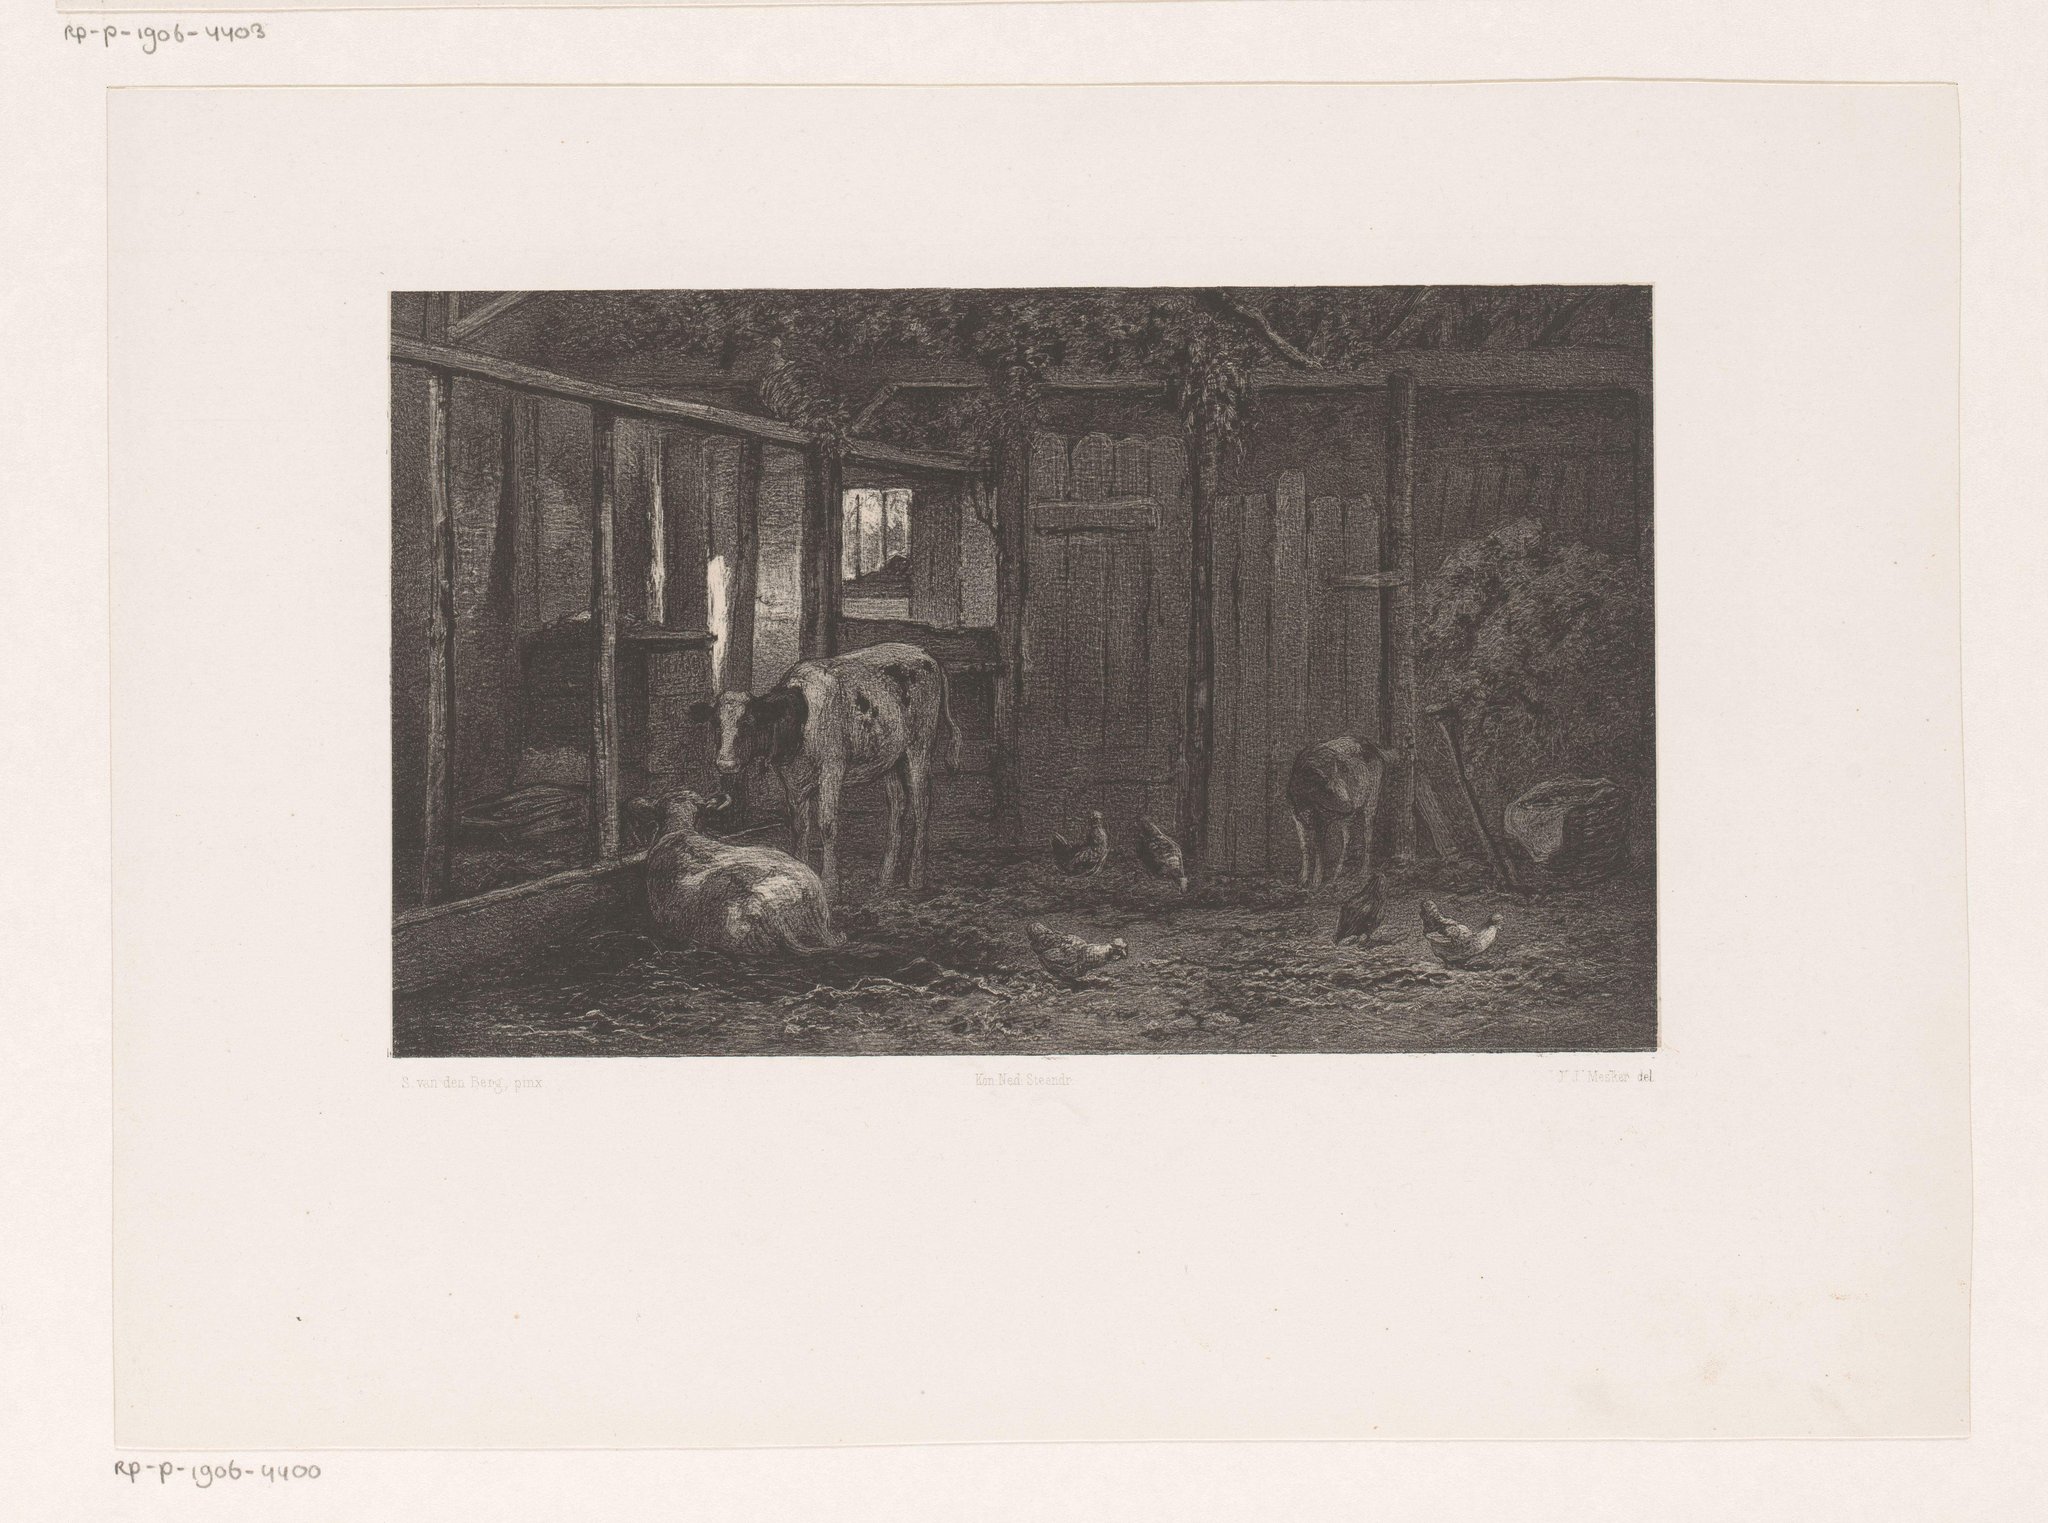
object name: print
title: Stal met koeien, kippen en een varken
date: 1867-1874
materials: paper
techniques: lithograph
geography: the hague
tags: pig, cow, fowl (cock, hen, chicken, etc.), stall, stable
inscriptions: collector's mark: Lugt 2228